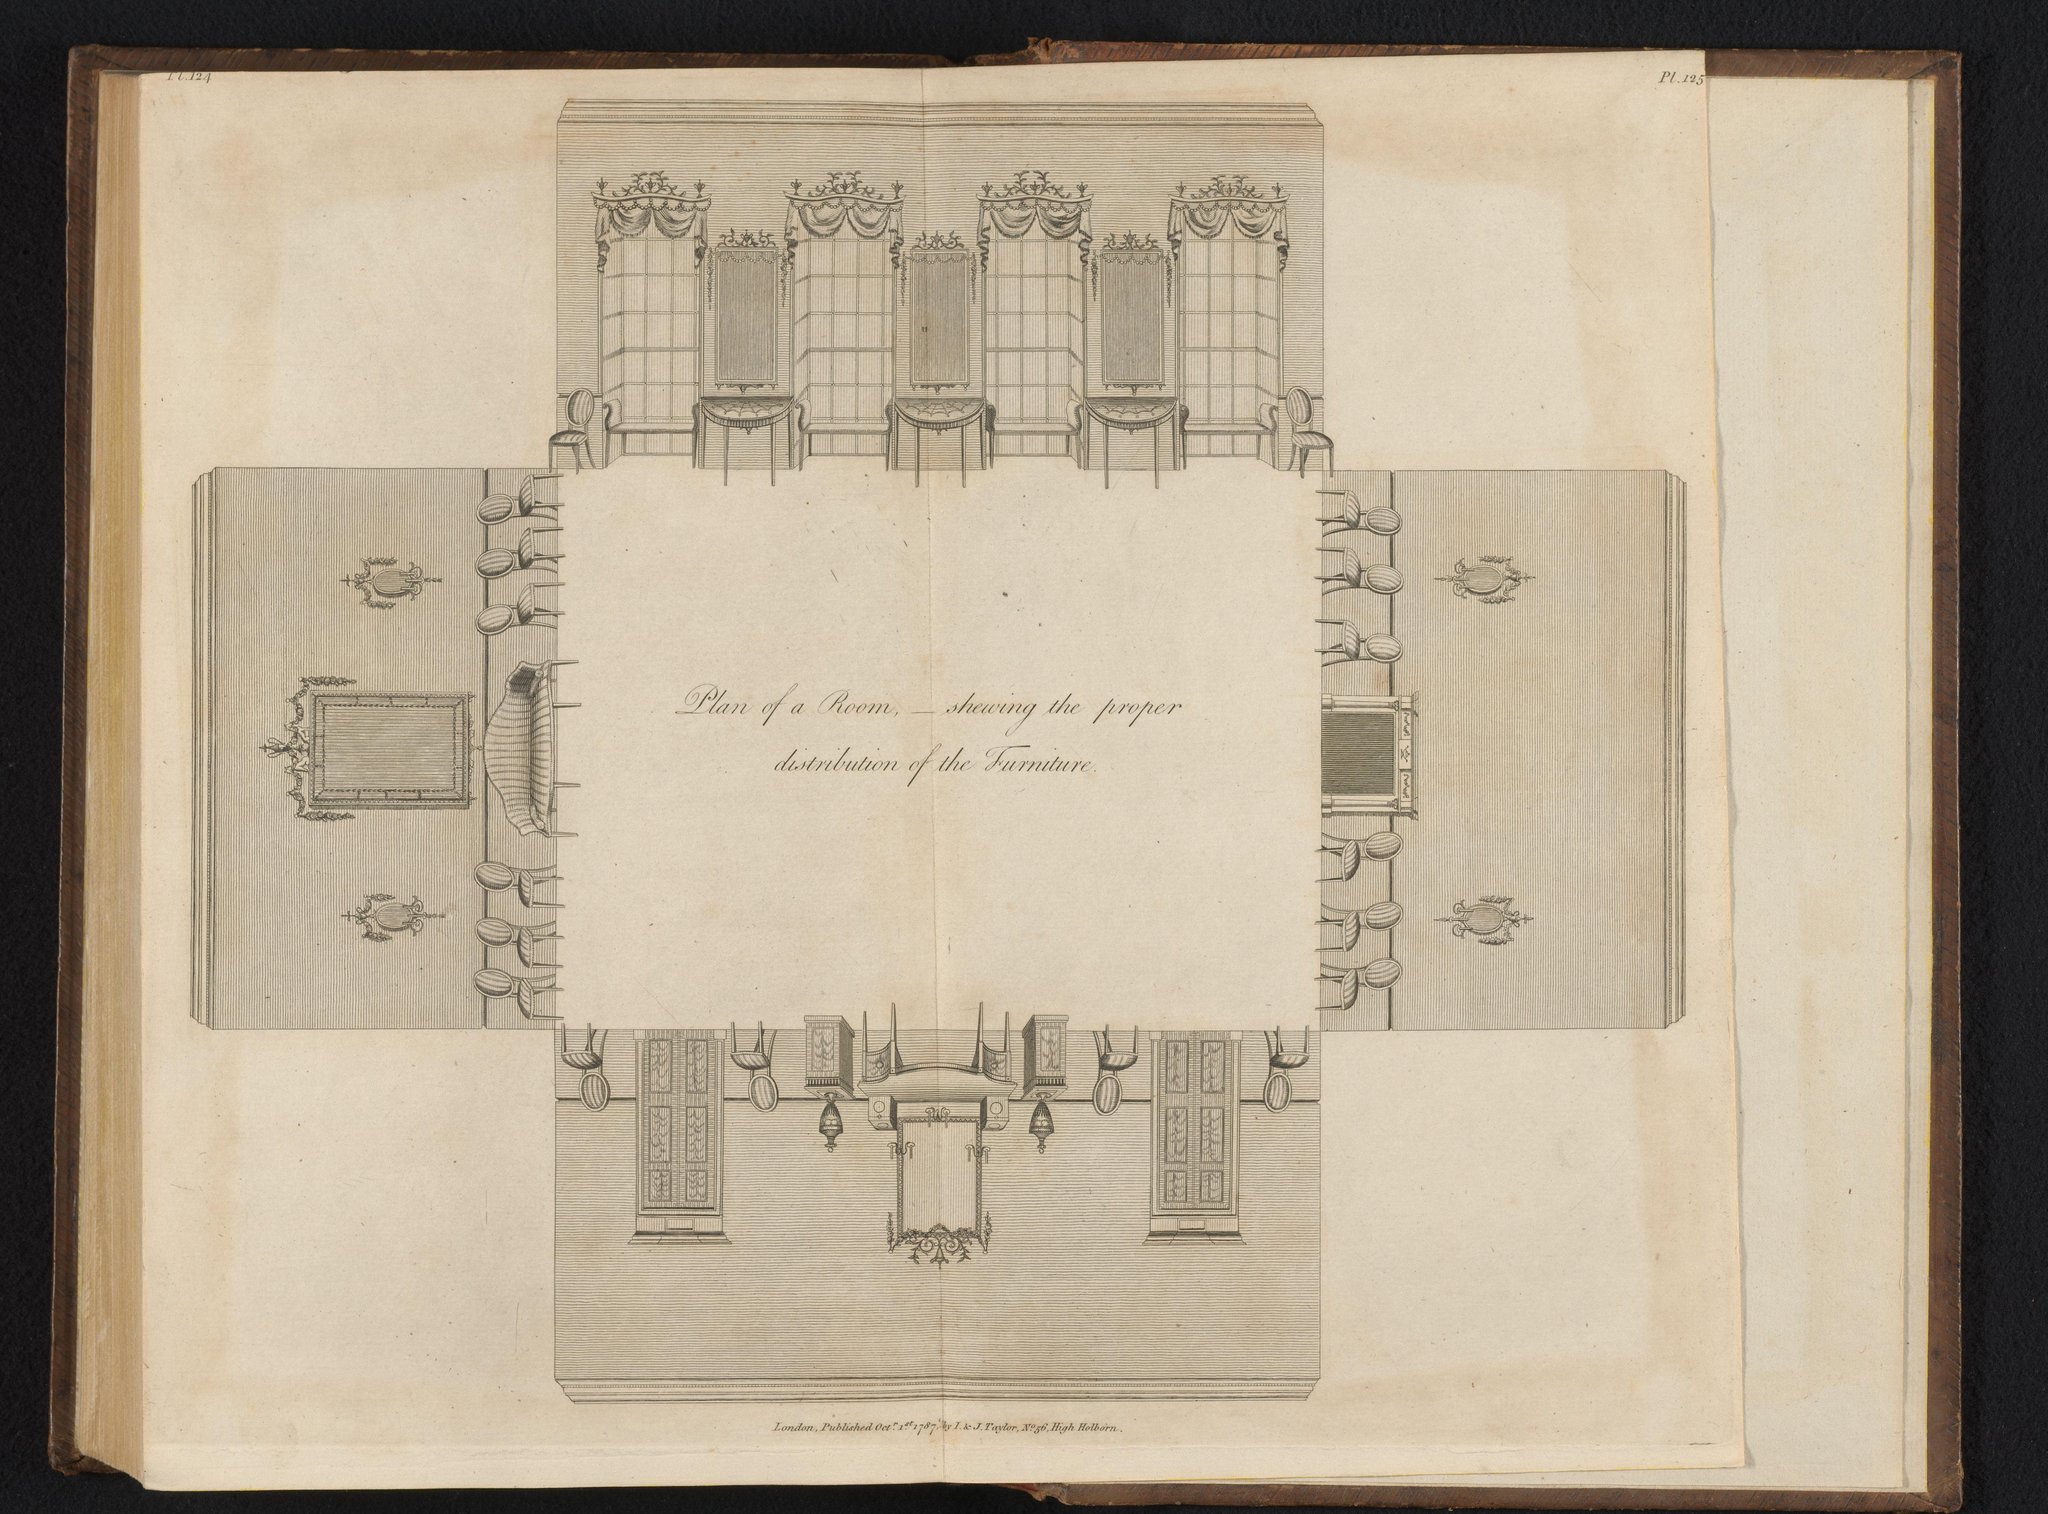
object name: page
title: Plan of a Room, showering the proper distribution of the Furniture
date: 1787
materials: paper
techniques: engraving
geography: holborn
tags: design, plan (~ production), furniture and household effects, living-room, parlour, sitting-room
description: Genummerd: Pl. 124 en 125. Prent maakt deel uit van een boek.